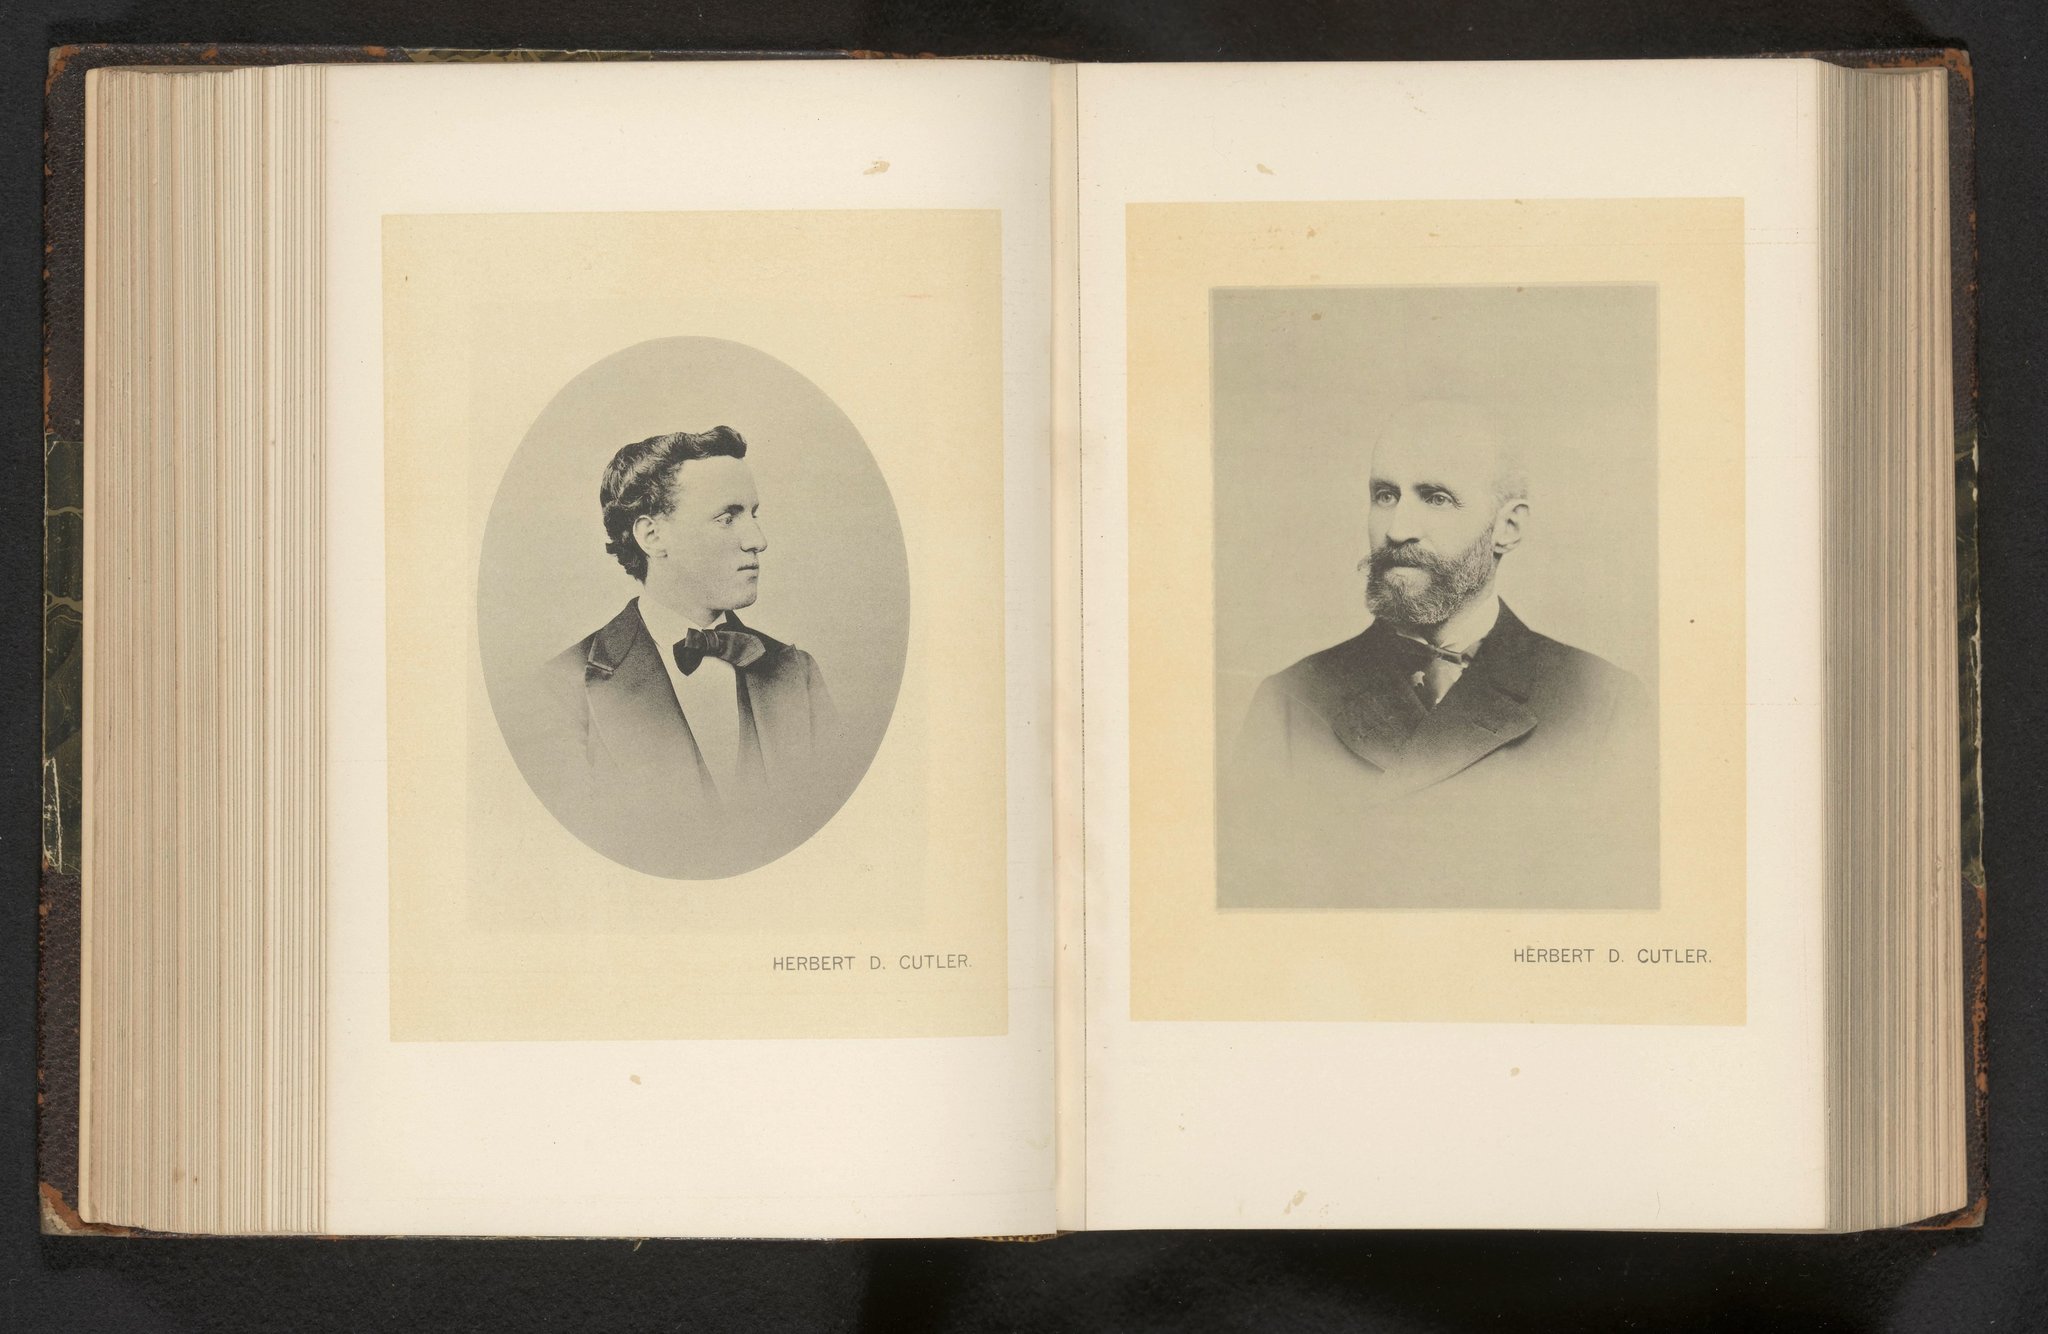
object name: photomechanical print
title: Herbert D. Cutler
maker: Anonymous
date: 1889-1894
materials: paper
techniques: photoaquatint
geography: boston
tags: adult man